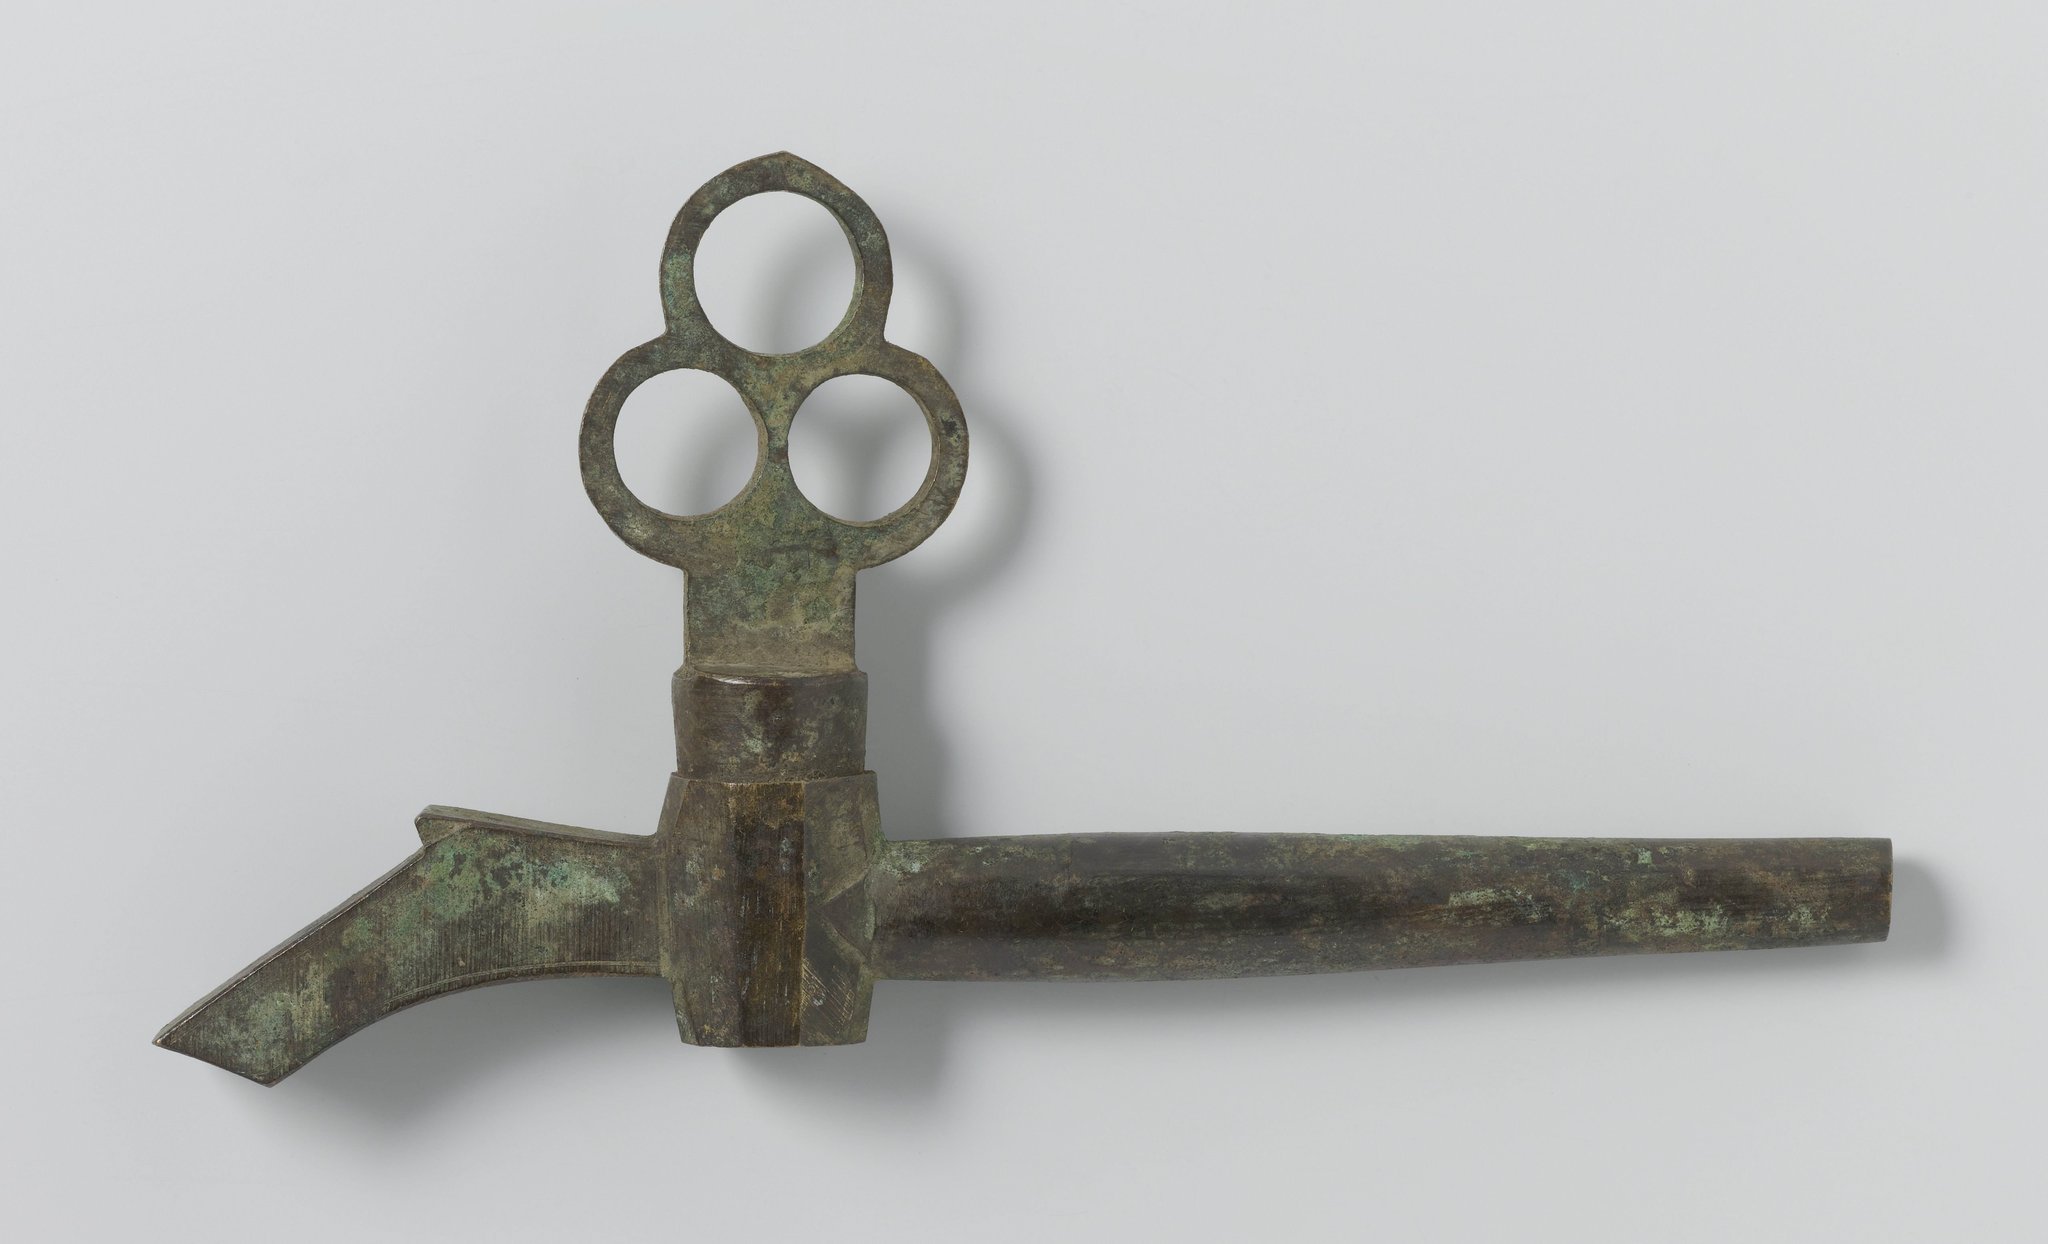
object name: spigot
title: Kraan van koper waarvan het handvat is samengesteld uit drie 'ringen'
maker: Anonymous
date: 1590-1596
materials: copper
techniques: casting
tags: willem barendsz., amsterdam, jacob van heemskerck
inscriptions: mark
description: Kraan van koper waarvan het handvat is samengesteld uit drie 'ringen'. Compleet.